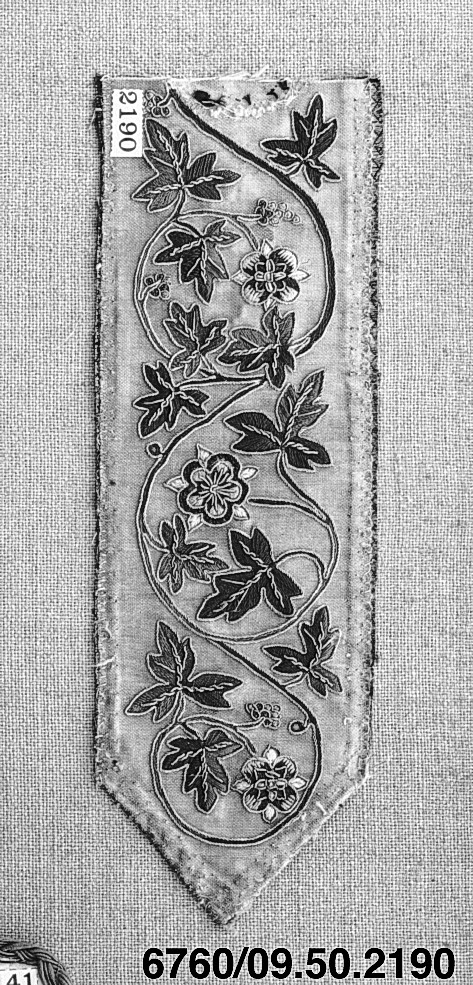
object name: cap band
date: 1767-1833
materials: metal thread, silk